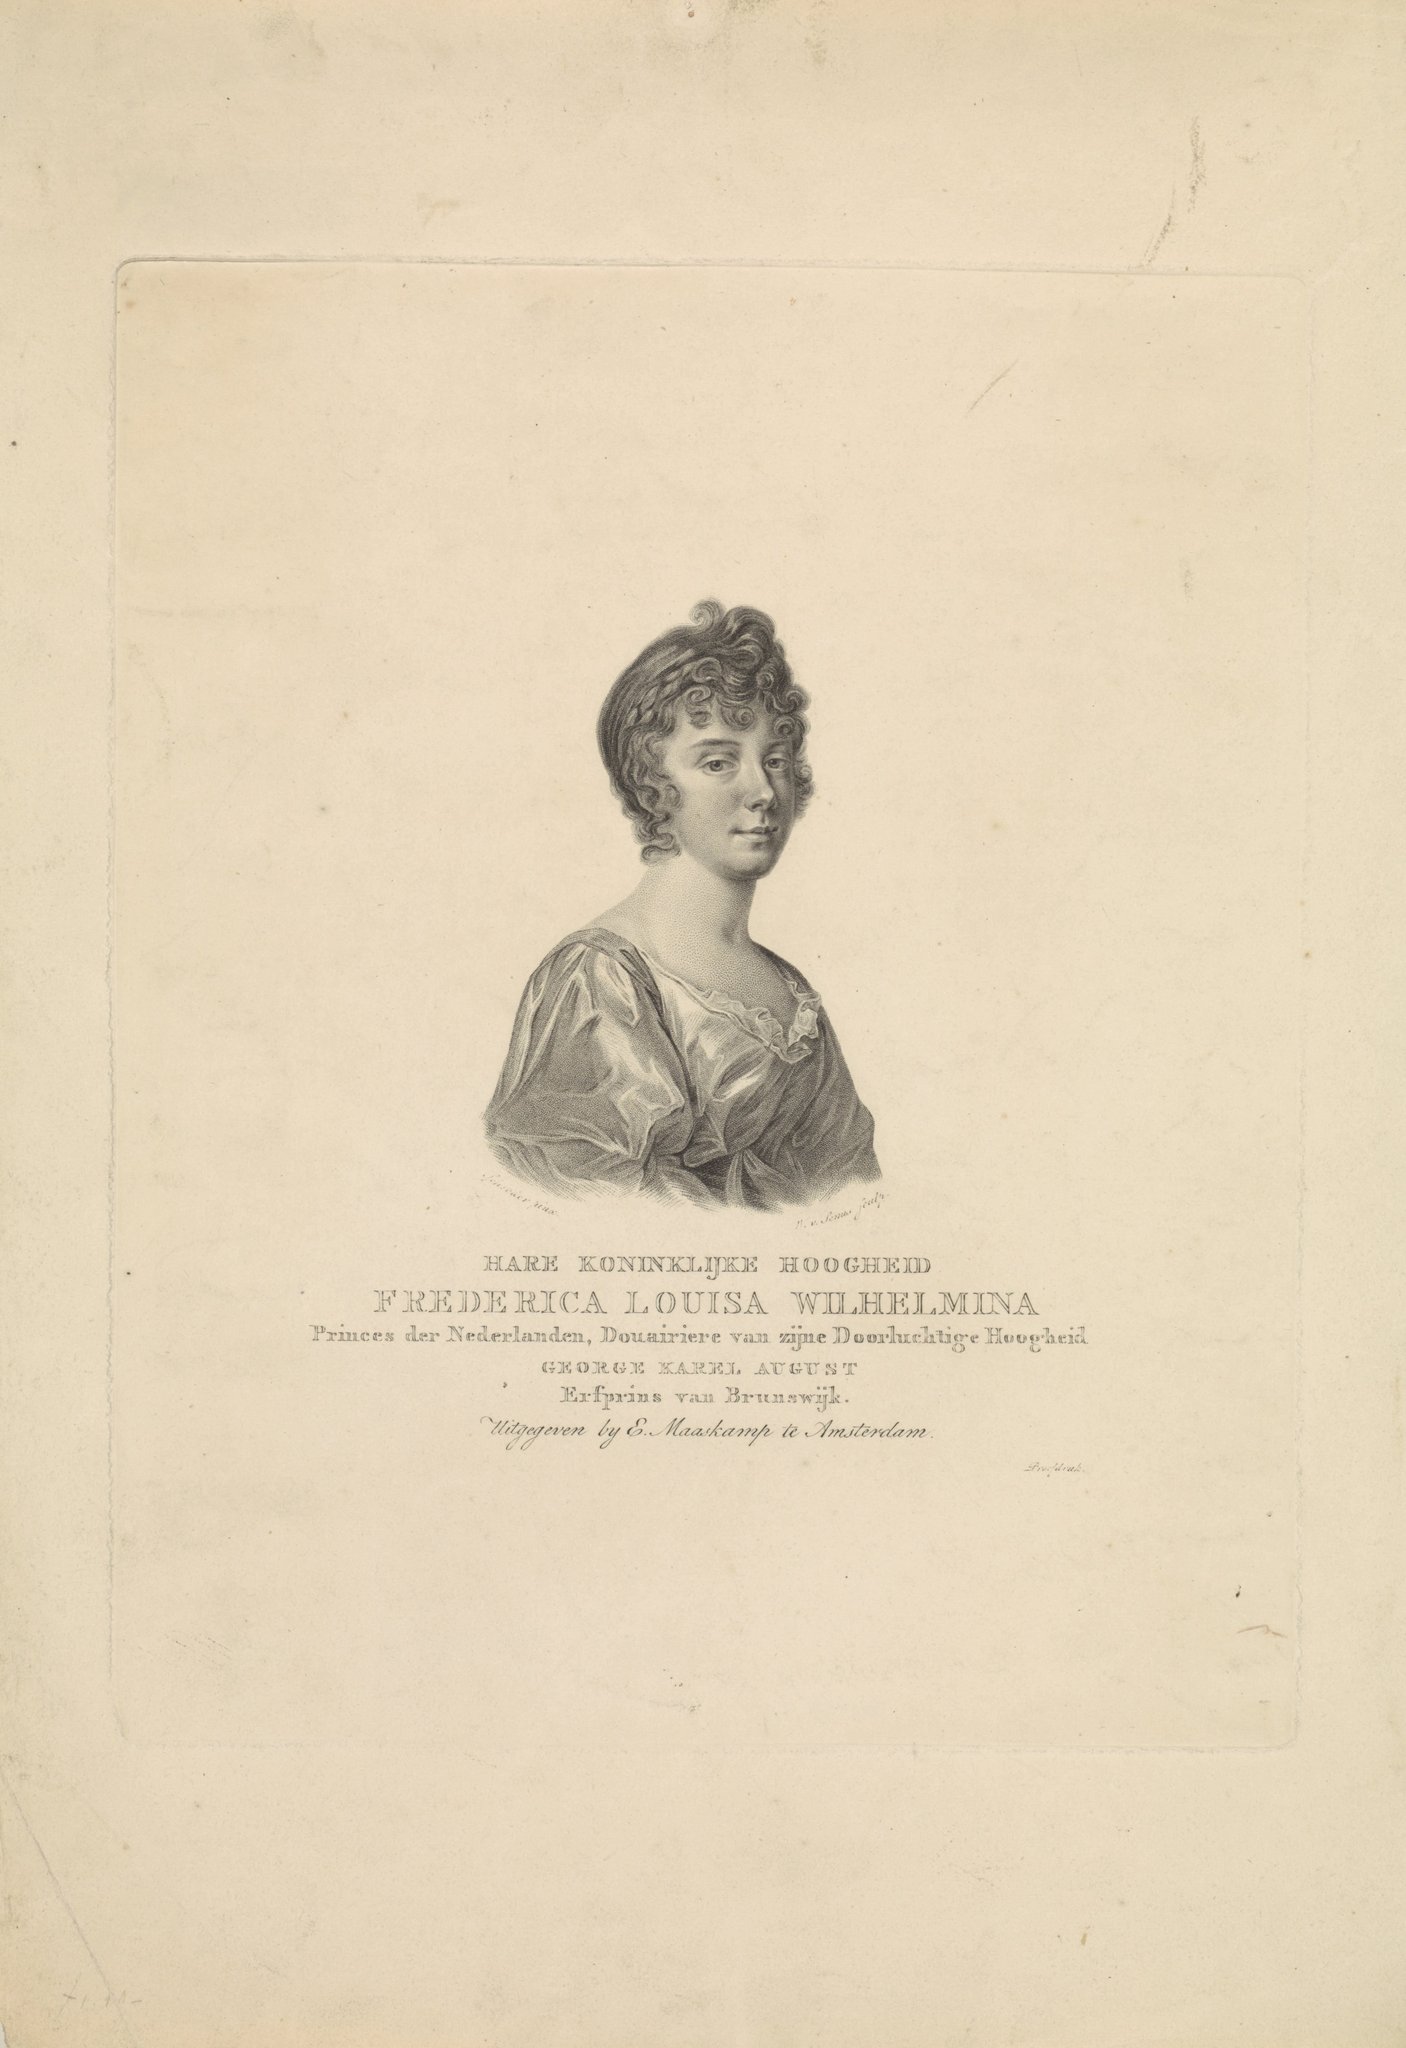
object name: print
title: Portret van Frederica Louisa Wilhelmina (prinses van Oranje-Nassau)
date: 1790-1851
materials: paper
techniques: etching, roulette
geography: amsterdam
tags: the hague, louise (prinses van oranje-nassau)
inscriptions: collector's mark: Lugt 2228